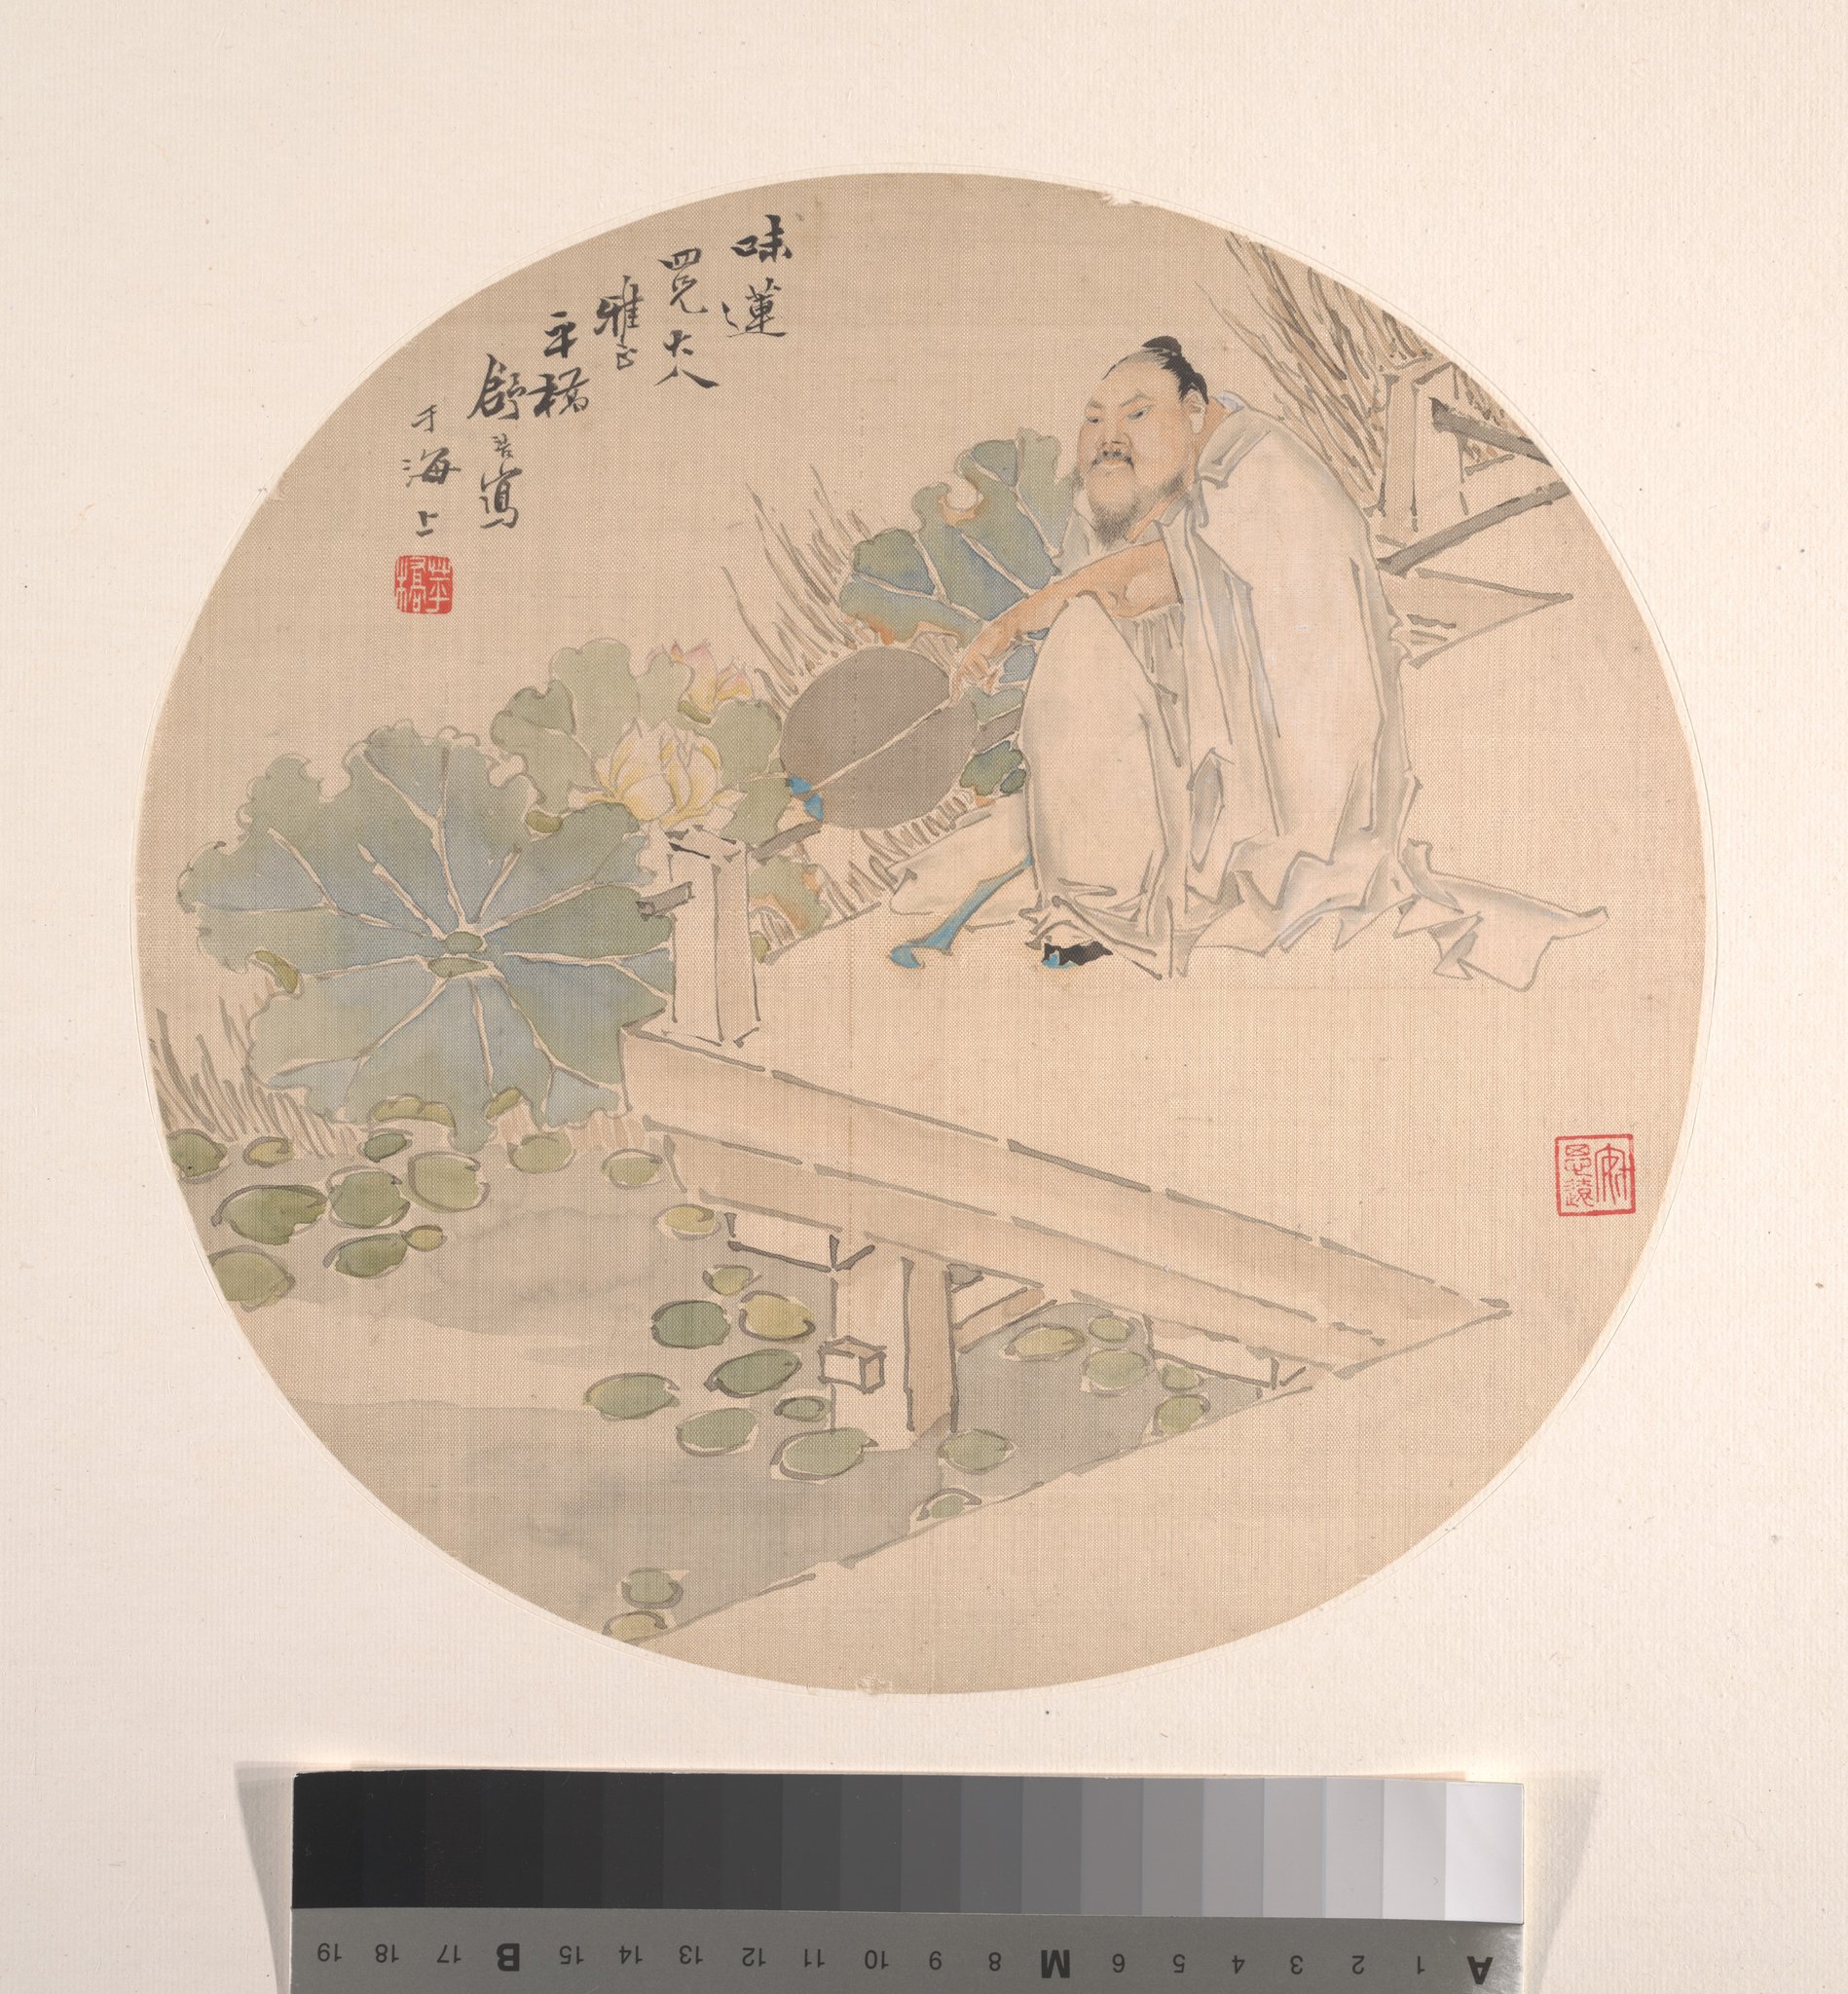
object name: fan mounted a an album leaf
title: Zhou Dunyi admiring lotus flowers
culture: chinese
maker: shu hao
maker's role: artist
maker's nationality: chinese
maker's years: 1868-1899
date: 1867-1900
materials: ink, silk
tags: men,lotuses